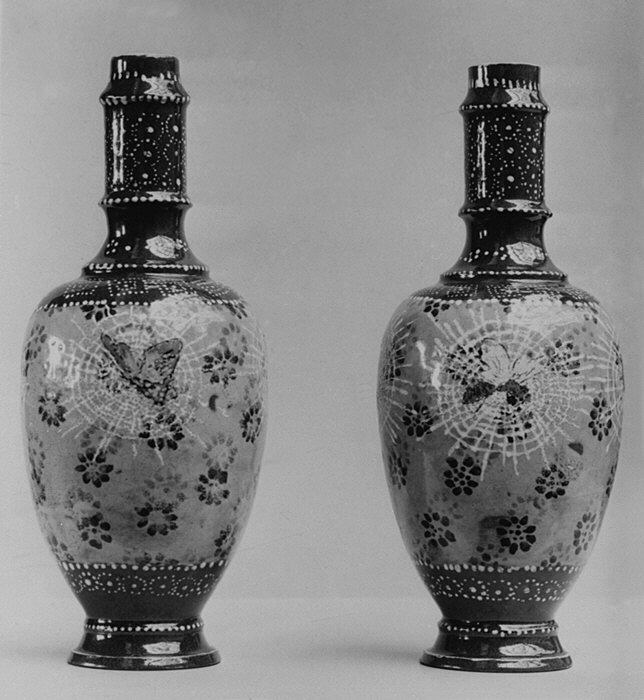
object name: vase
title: Pair of vases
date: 1870-1886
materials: stoneware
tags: insects,butterflies